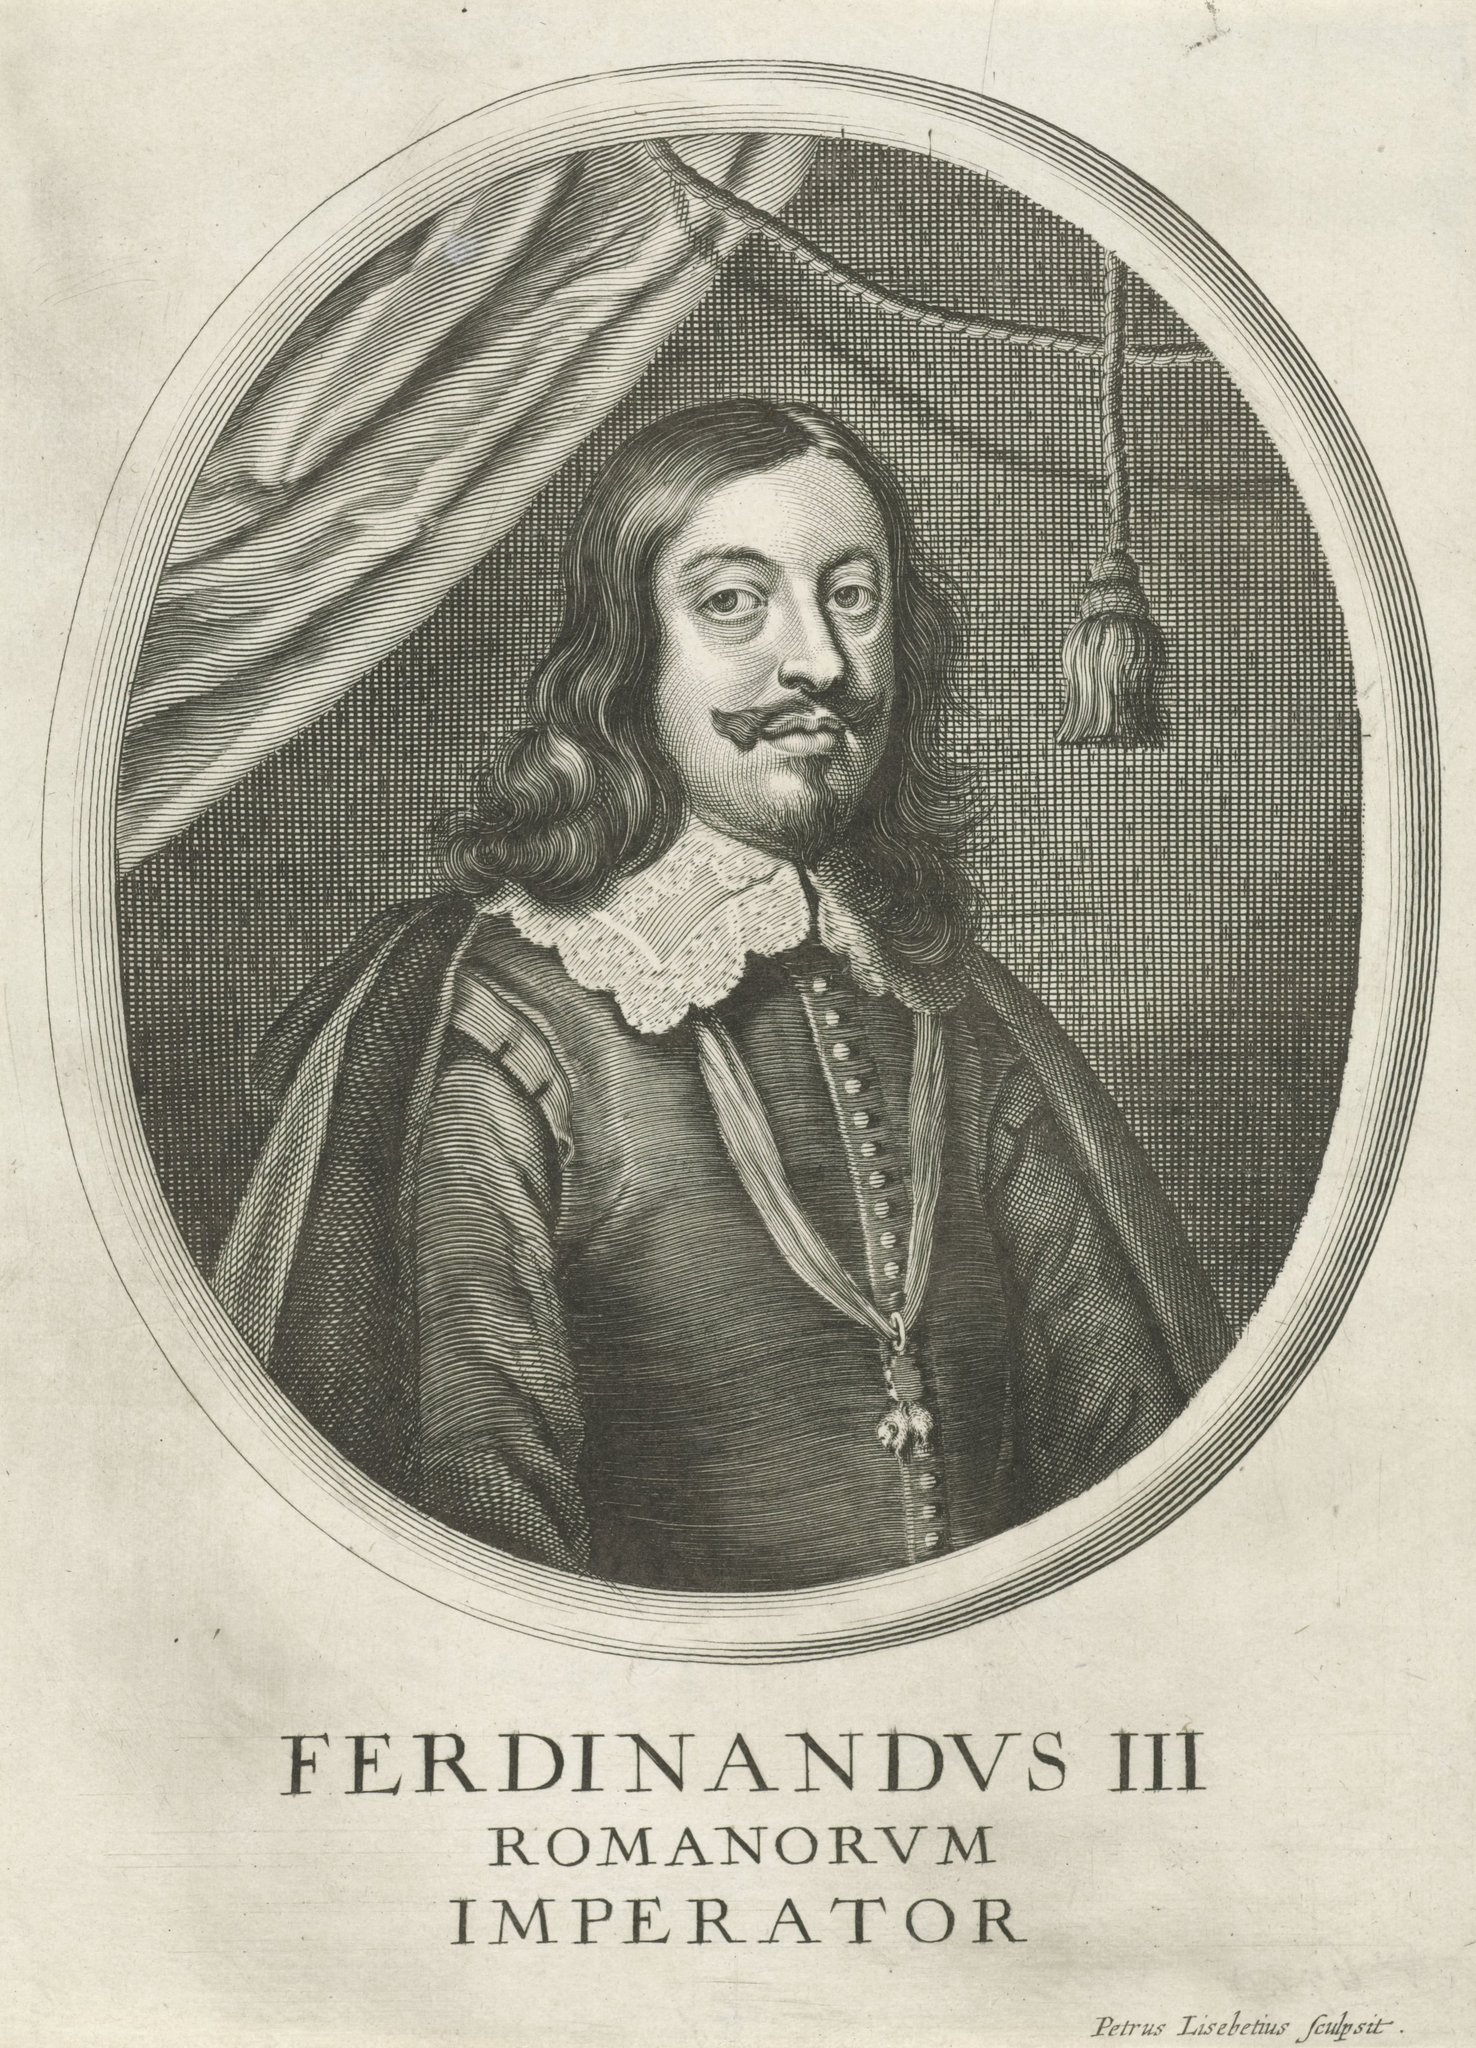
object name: print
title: Portret van keizer Ferdinand III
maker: peter van liesebetten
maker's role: print maker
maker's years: 1630-1678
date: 1640-1678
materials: paper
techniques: engraving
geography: antwerp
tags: ferdinand iii (duits keizer), knighthood order of the golden fleece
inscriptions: collector's mark: Lugt 2228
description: Portret van Ferdinand III, Duits keizer. Om zijn hals hangt een lint met het symbool van de orde van het Gulden Vlies.